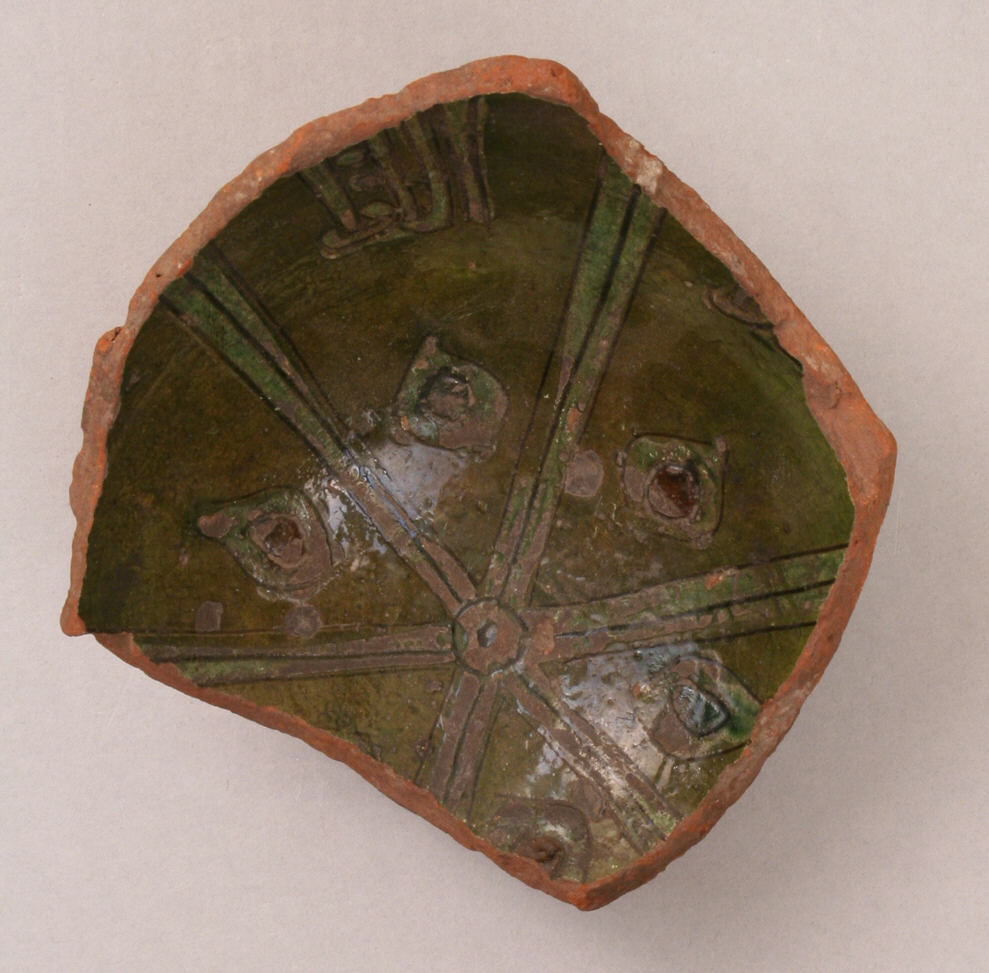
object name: ceramic fragment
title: Fragment of a Bowl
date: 1301-1500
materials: earthenware, glaze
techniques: coloring, incising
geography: egypt